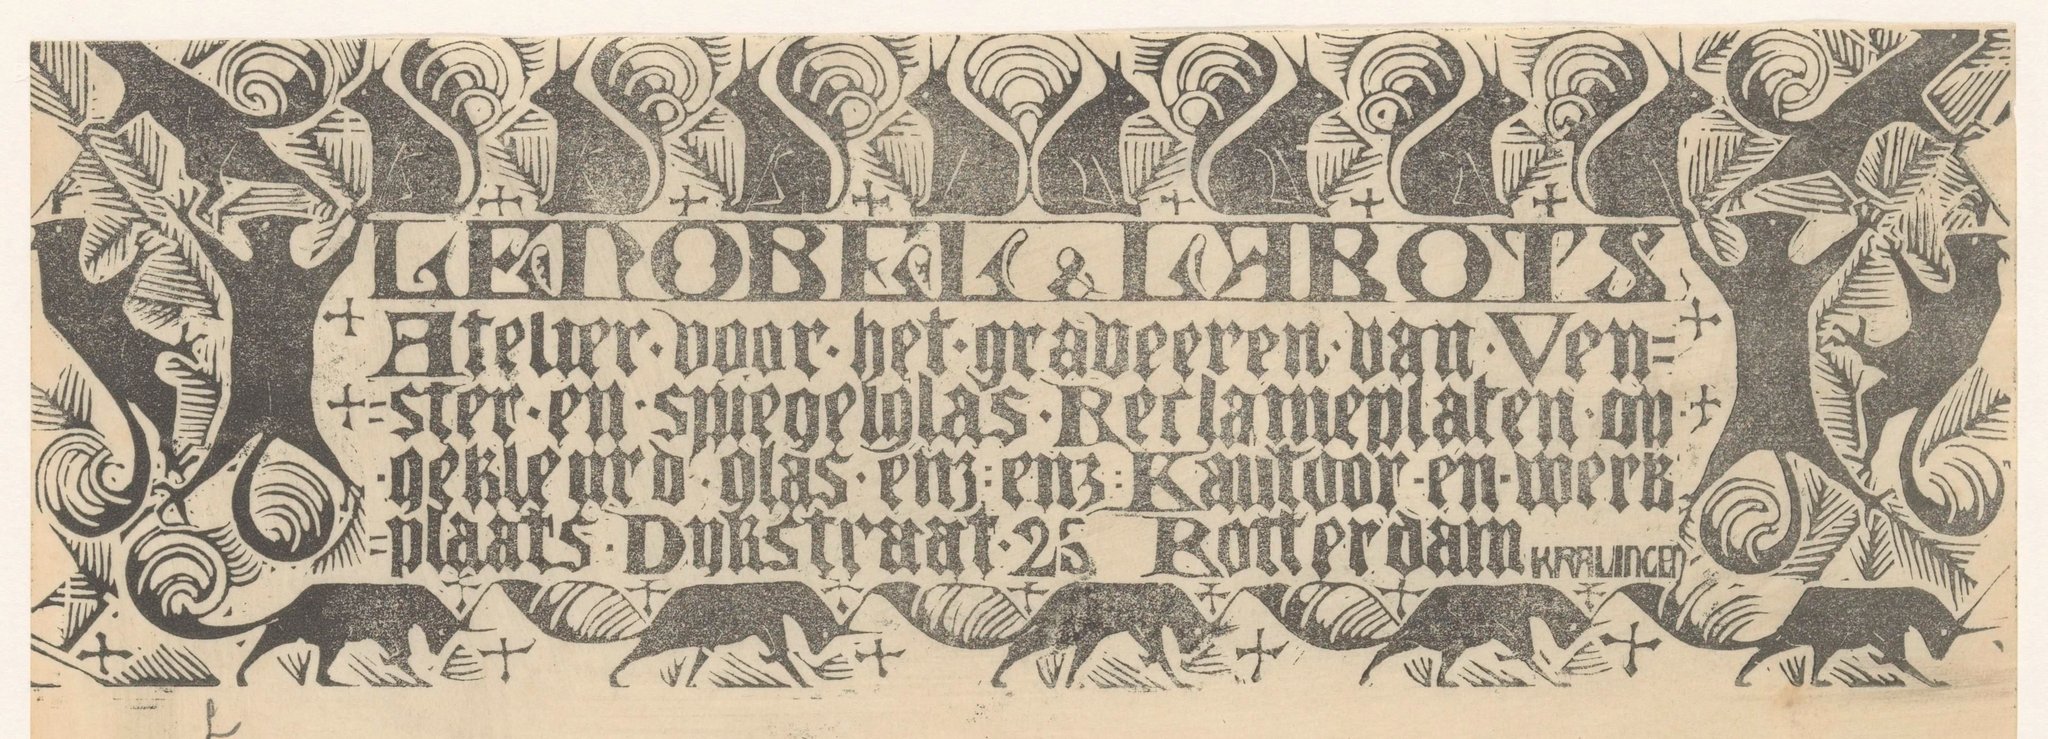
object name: letterhead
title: Briefhoofd van Le Nobel & Labots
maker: mathieu lauweriks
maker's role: designer, draughtsman, print maker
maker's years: 1864-1932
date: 1874-1932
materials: paper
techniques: woodcut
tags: hoofed animals: deer, rodents: squirrel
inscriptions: collector's mark: Lugt 2228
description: Briefhoofd van het atelier Le Nobel & Labots met een ornamentrand met eekhoorns en herten.